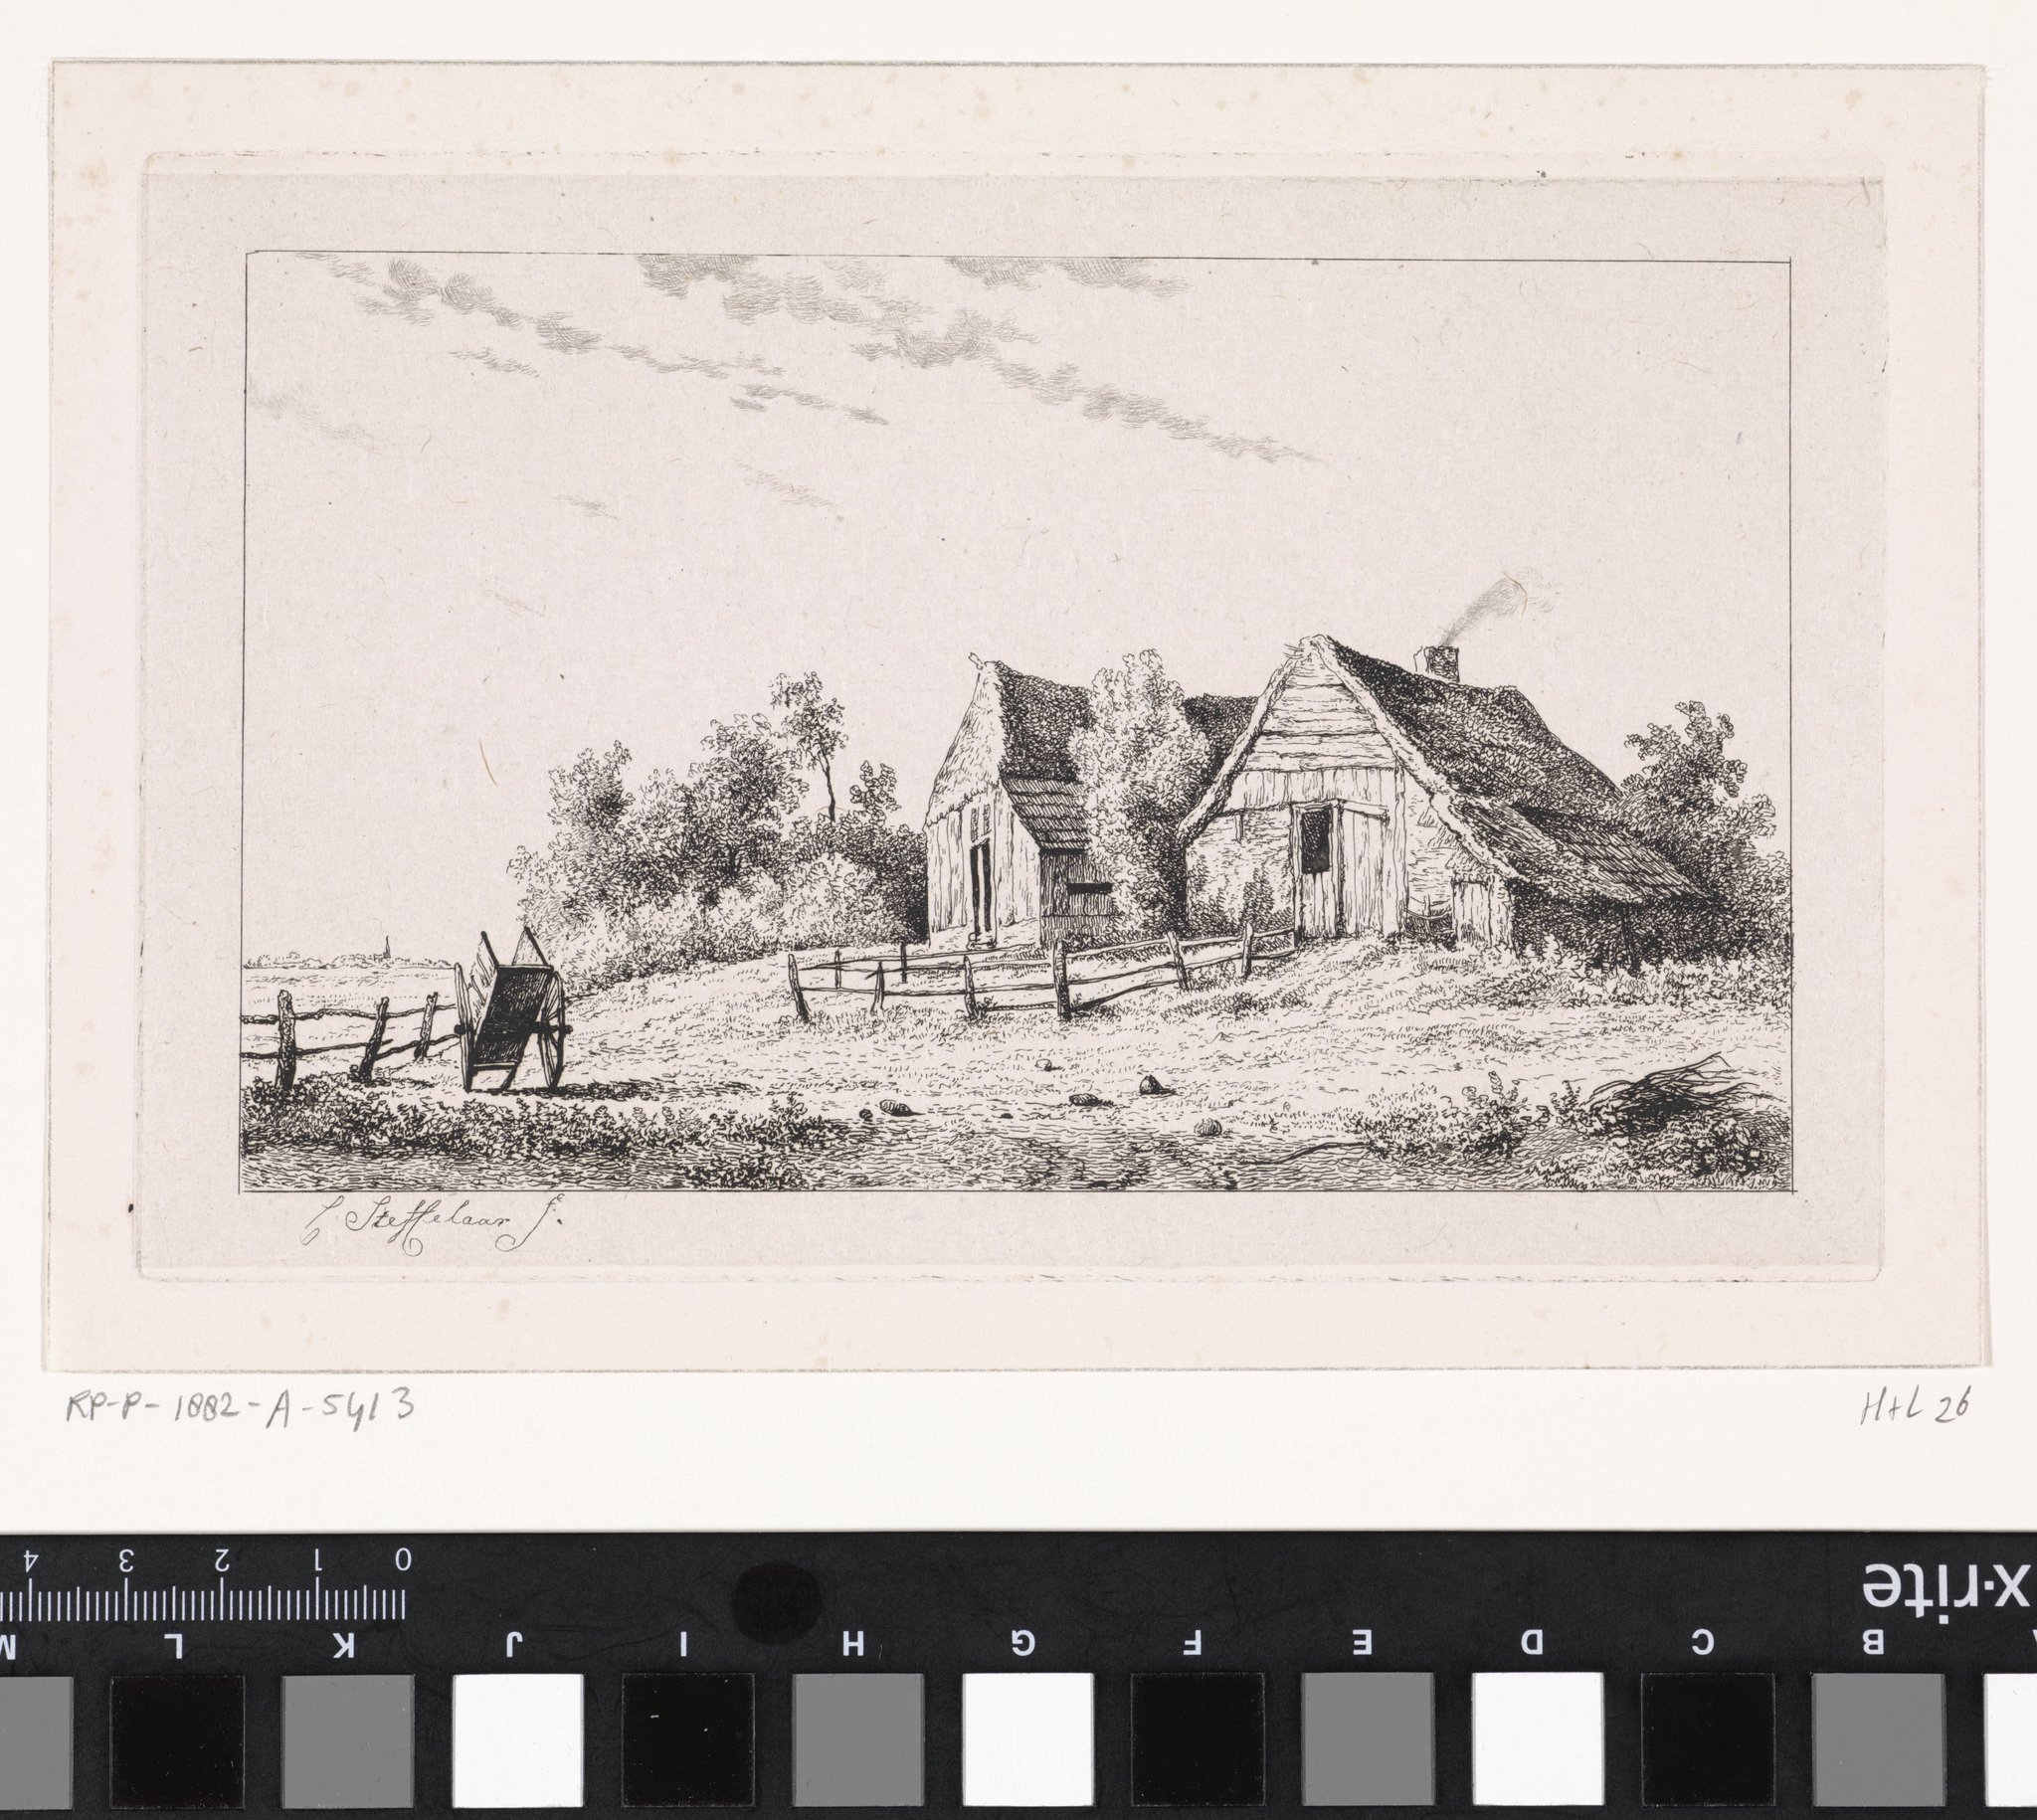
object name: print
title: Derde suite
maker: cornelis steffelaar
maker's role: draughtsman, painter, print maker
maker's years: 1797-1861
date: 1807-1861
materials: paper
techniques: etching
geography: amsterdam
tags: (farm) wagon, freight wagon, cart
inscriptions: collector's mark: Lugt 2228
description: Landschap met twee houten huizen en links een kar.